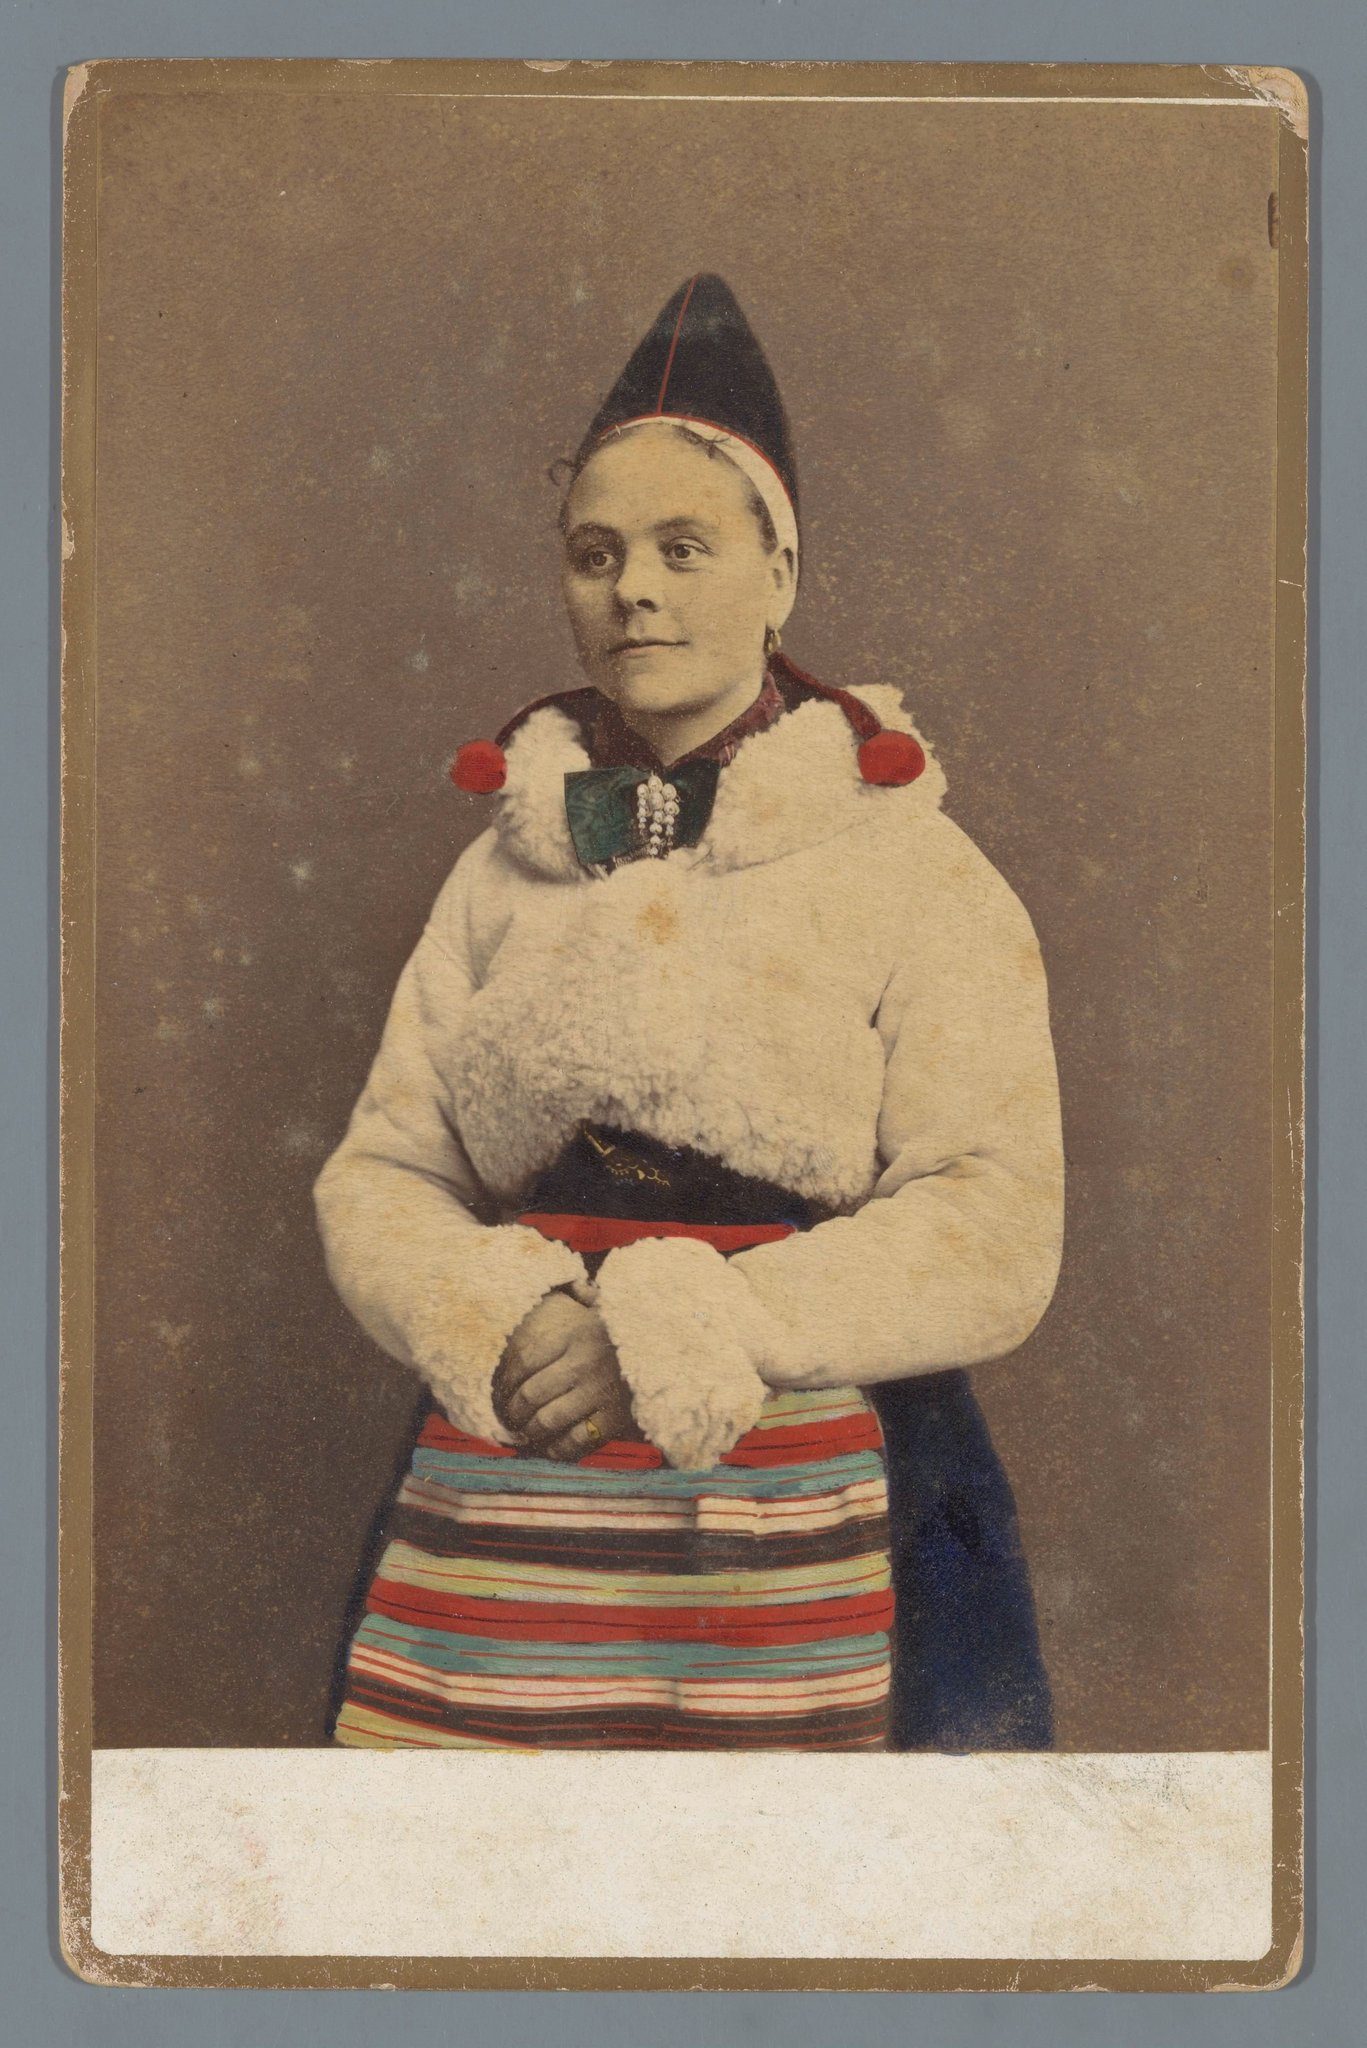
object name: cabinet photograph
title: Portret van een onbekende vrouw in klederdracht van vermoedelijk Leksand in Zweden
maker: wilhelm abraham eurenius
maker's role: fotograaf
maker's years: -1892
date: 1870-1890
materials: cardboard, photographic support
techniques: albumen print, hand coloring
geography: stockholm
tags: folk costume, regional costume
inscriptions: name: ‘W. Eurenius, Kongl. Hoffotograf Stockholm Hamngatan No. 18.’, inscription: ‘Leksand’